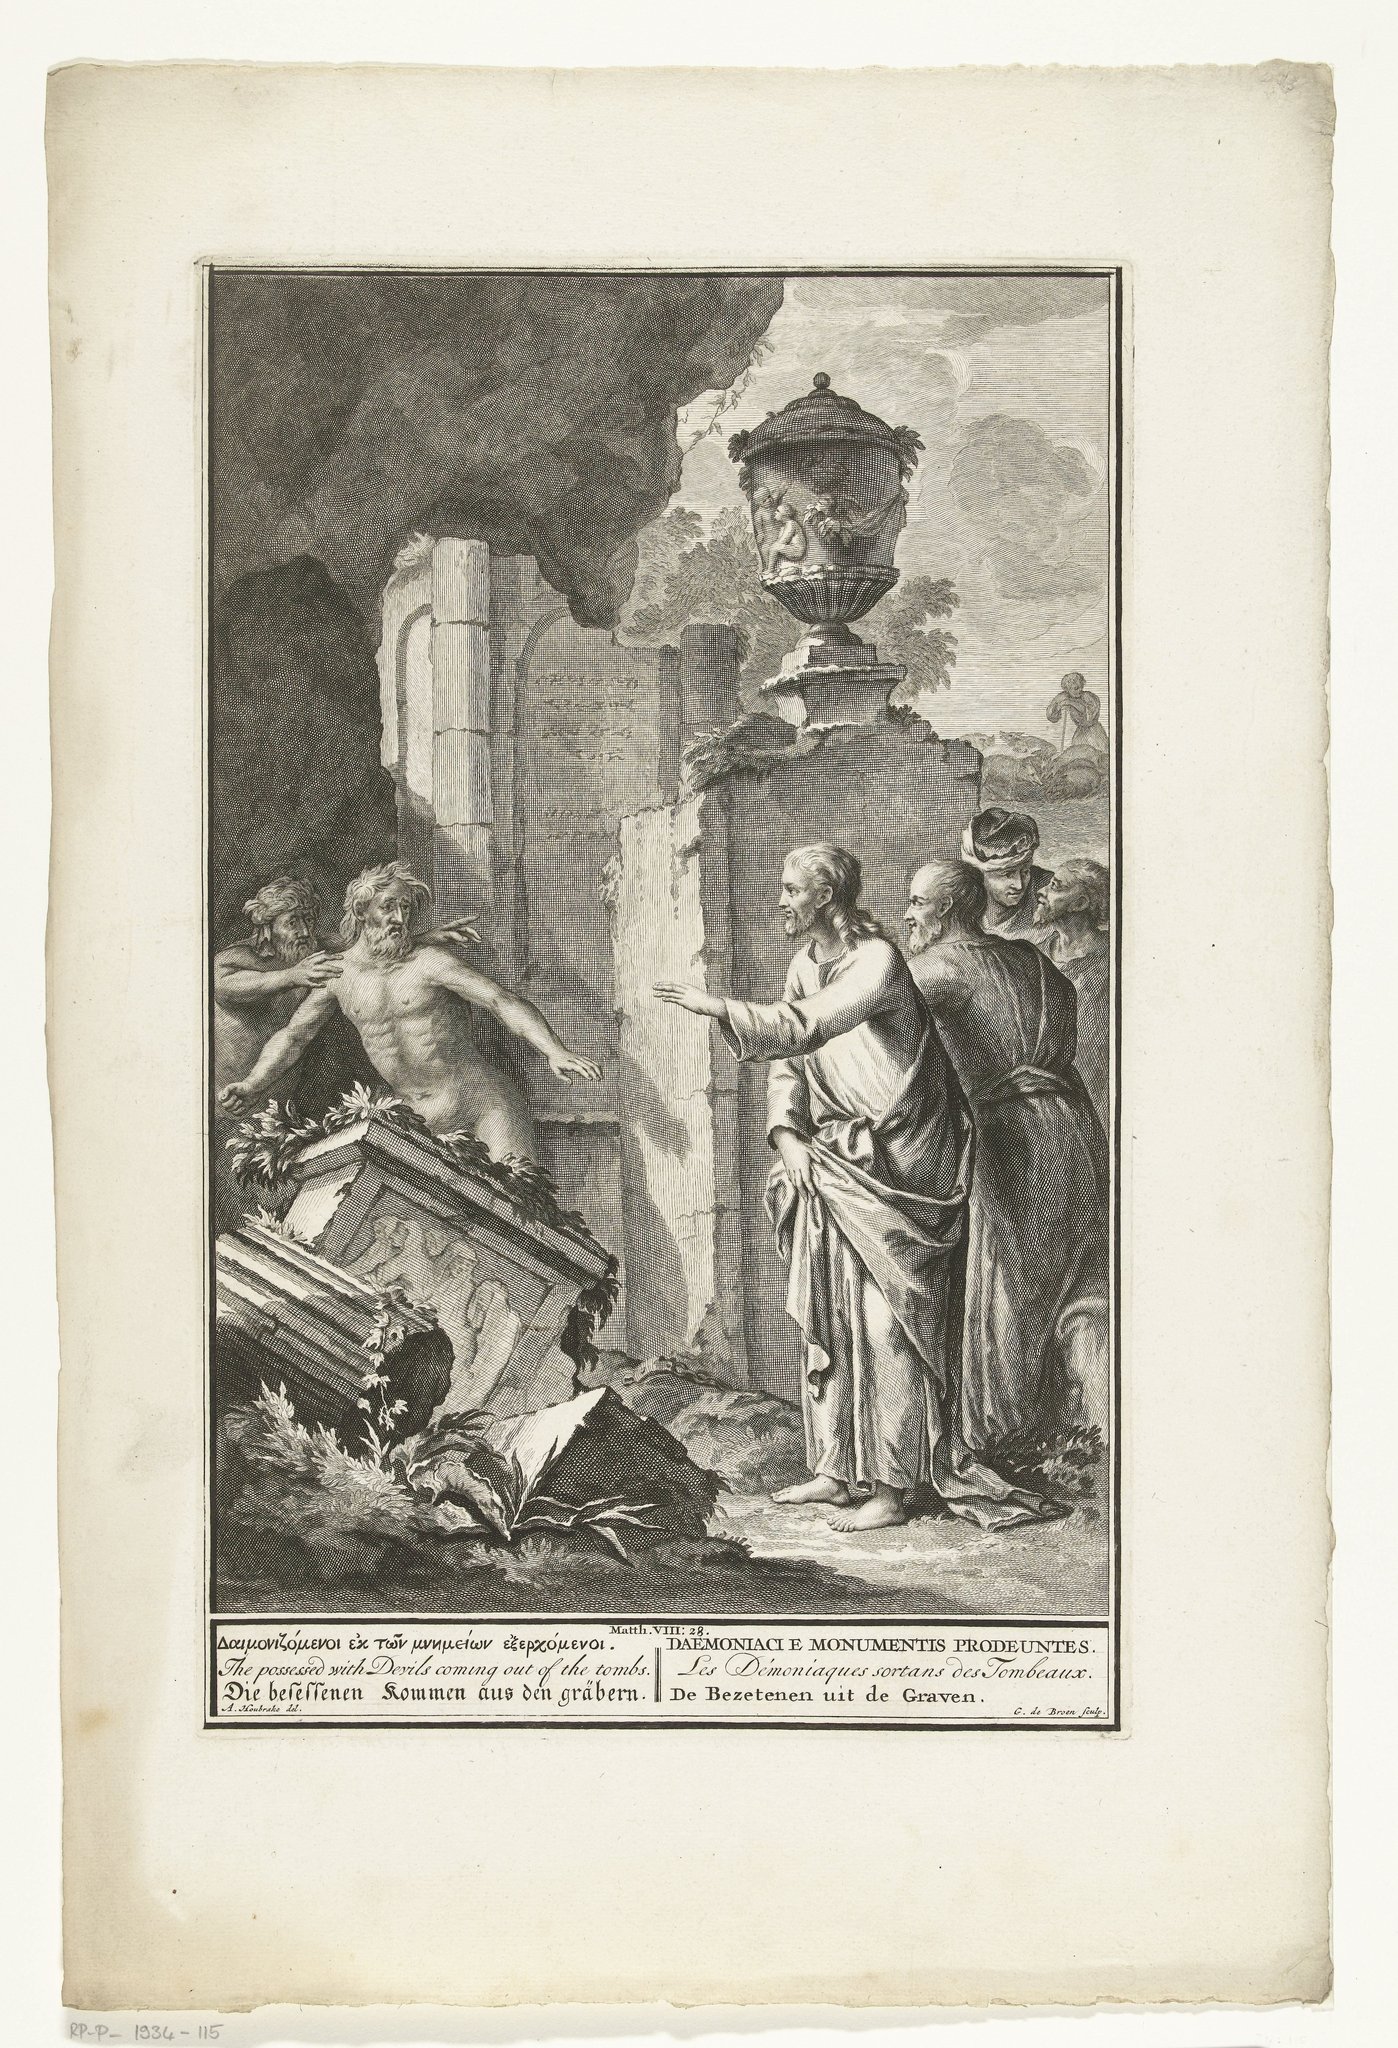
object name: book illustration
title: Christus en de bezetenen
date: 1720-1728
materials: paper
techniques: engraving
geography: amsterdam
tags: healing of two (or one) possessed at gerasa (gadara) (matthew 8:28-34; mark 5:1-20; luke 8:26-39)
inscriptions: inscription: ‘Utrechts Fundatie huys’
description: Christus en zijn leerlingen komen bij een graf twee bezetenen tegemoet. Niemand durft langs de bezetenen te lopen. Zij vragen Christus om hulp en hij stuurt hen naar een kudde varkens die verderop bij een meer liggen. De varkens storten zich allemaal in het meer en de bezetenen zijn verlost van hun demonen. Illustratie uit het Nieuwe Testament, Mat. 8, 28. Onder de voorstelling een titel in het Grieks, Engels, Duits, Latijn, Frans en Nederlands.